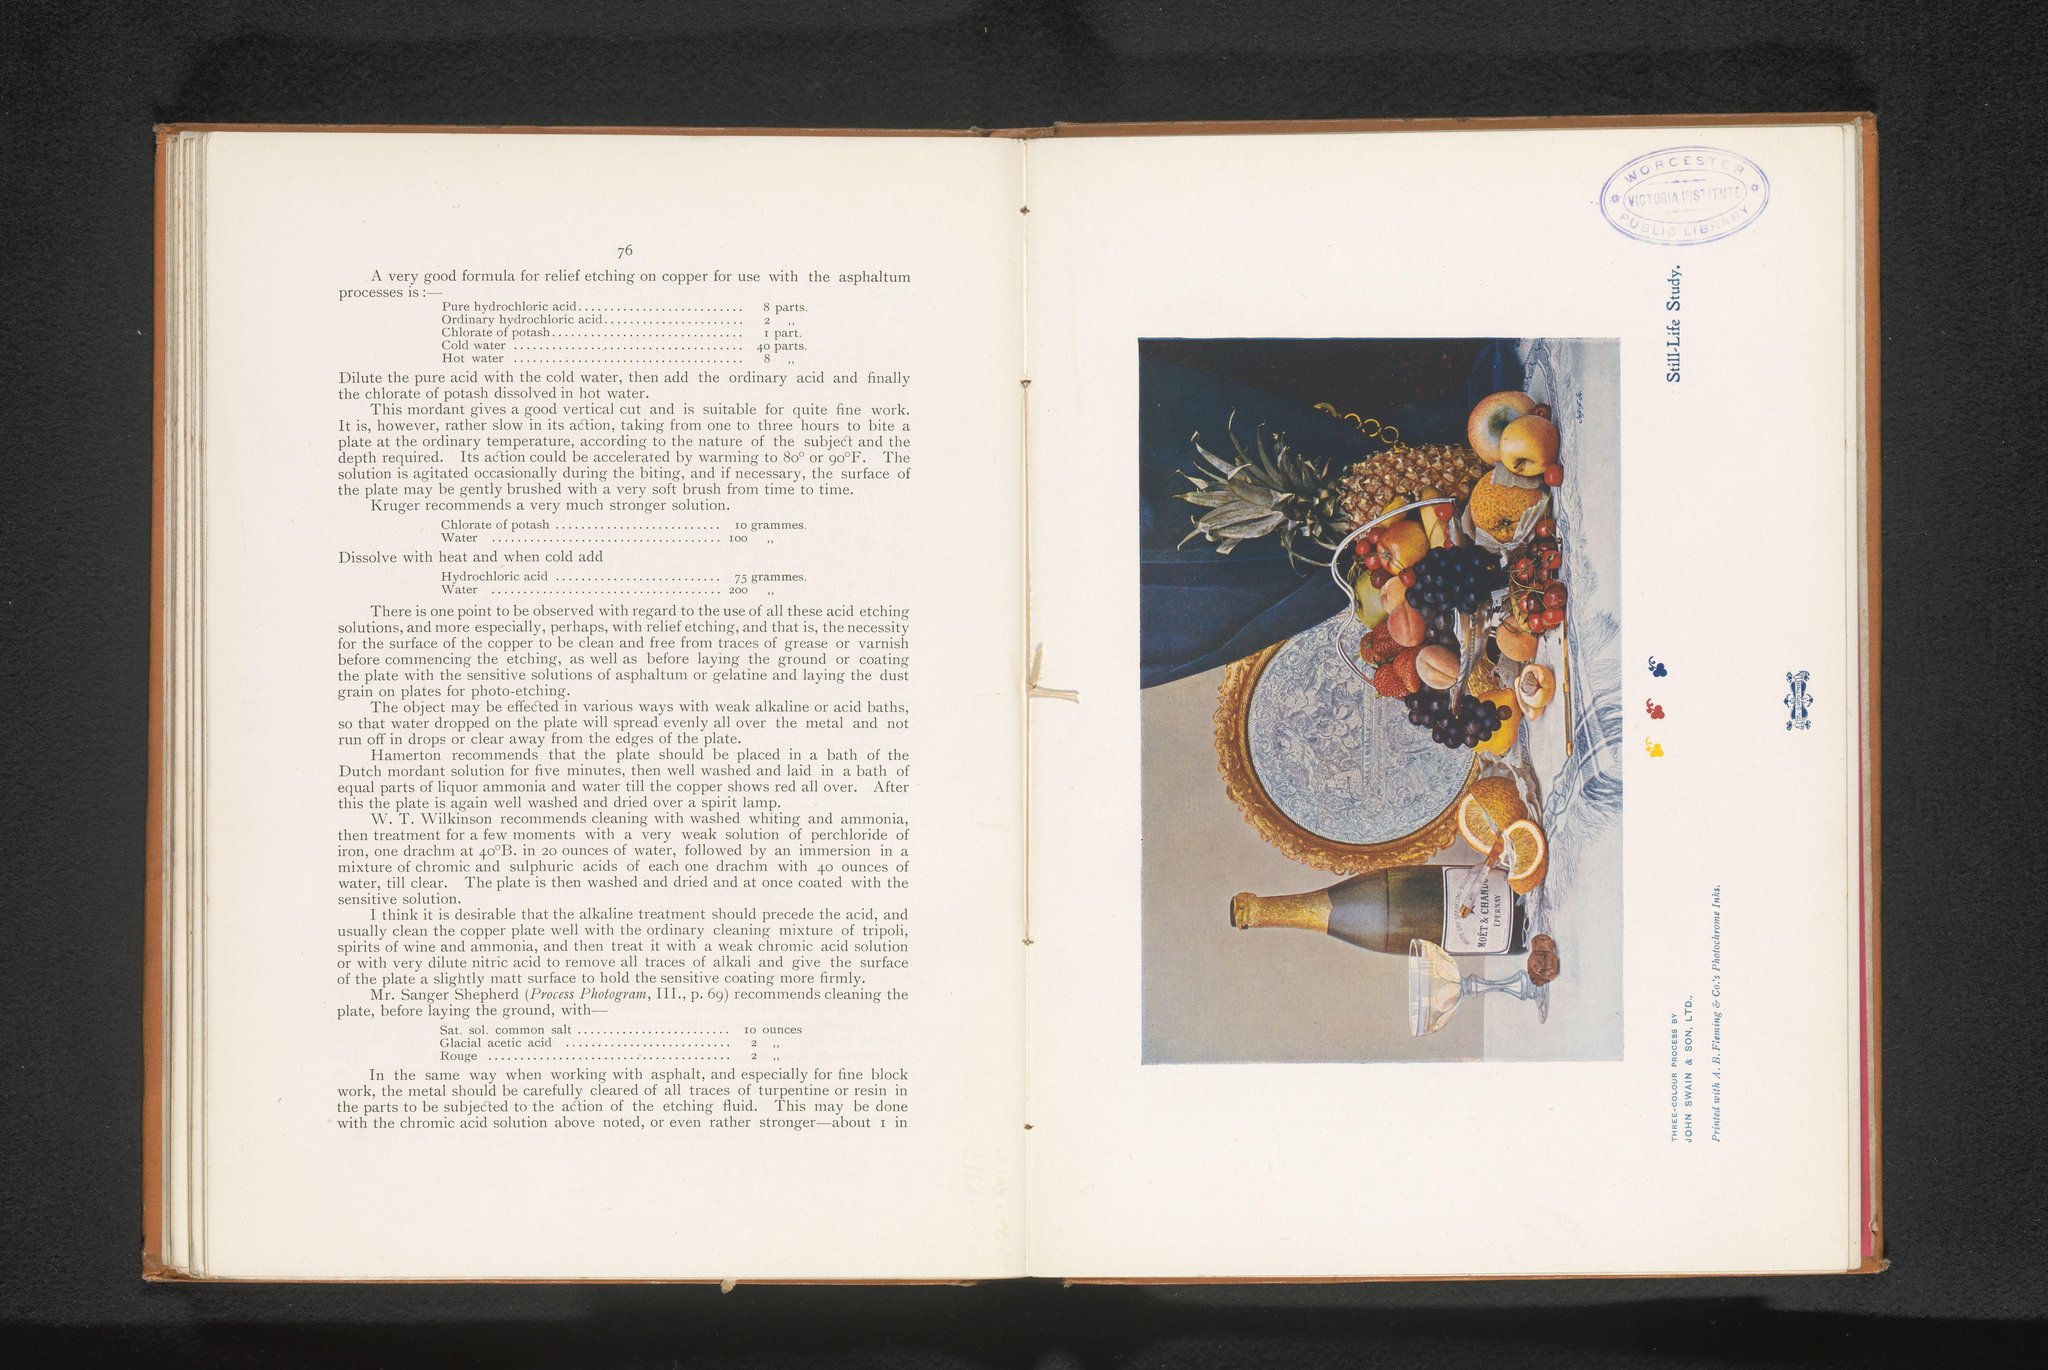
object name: page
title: Stilleven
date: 1894-1899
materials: paper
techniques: three-color autotype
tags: laid table as still life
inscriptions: collector's mark: ‘Worcester Public Library/ Victoria Institute’